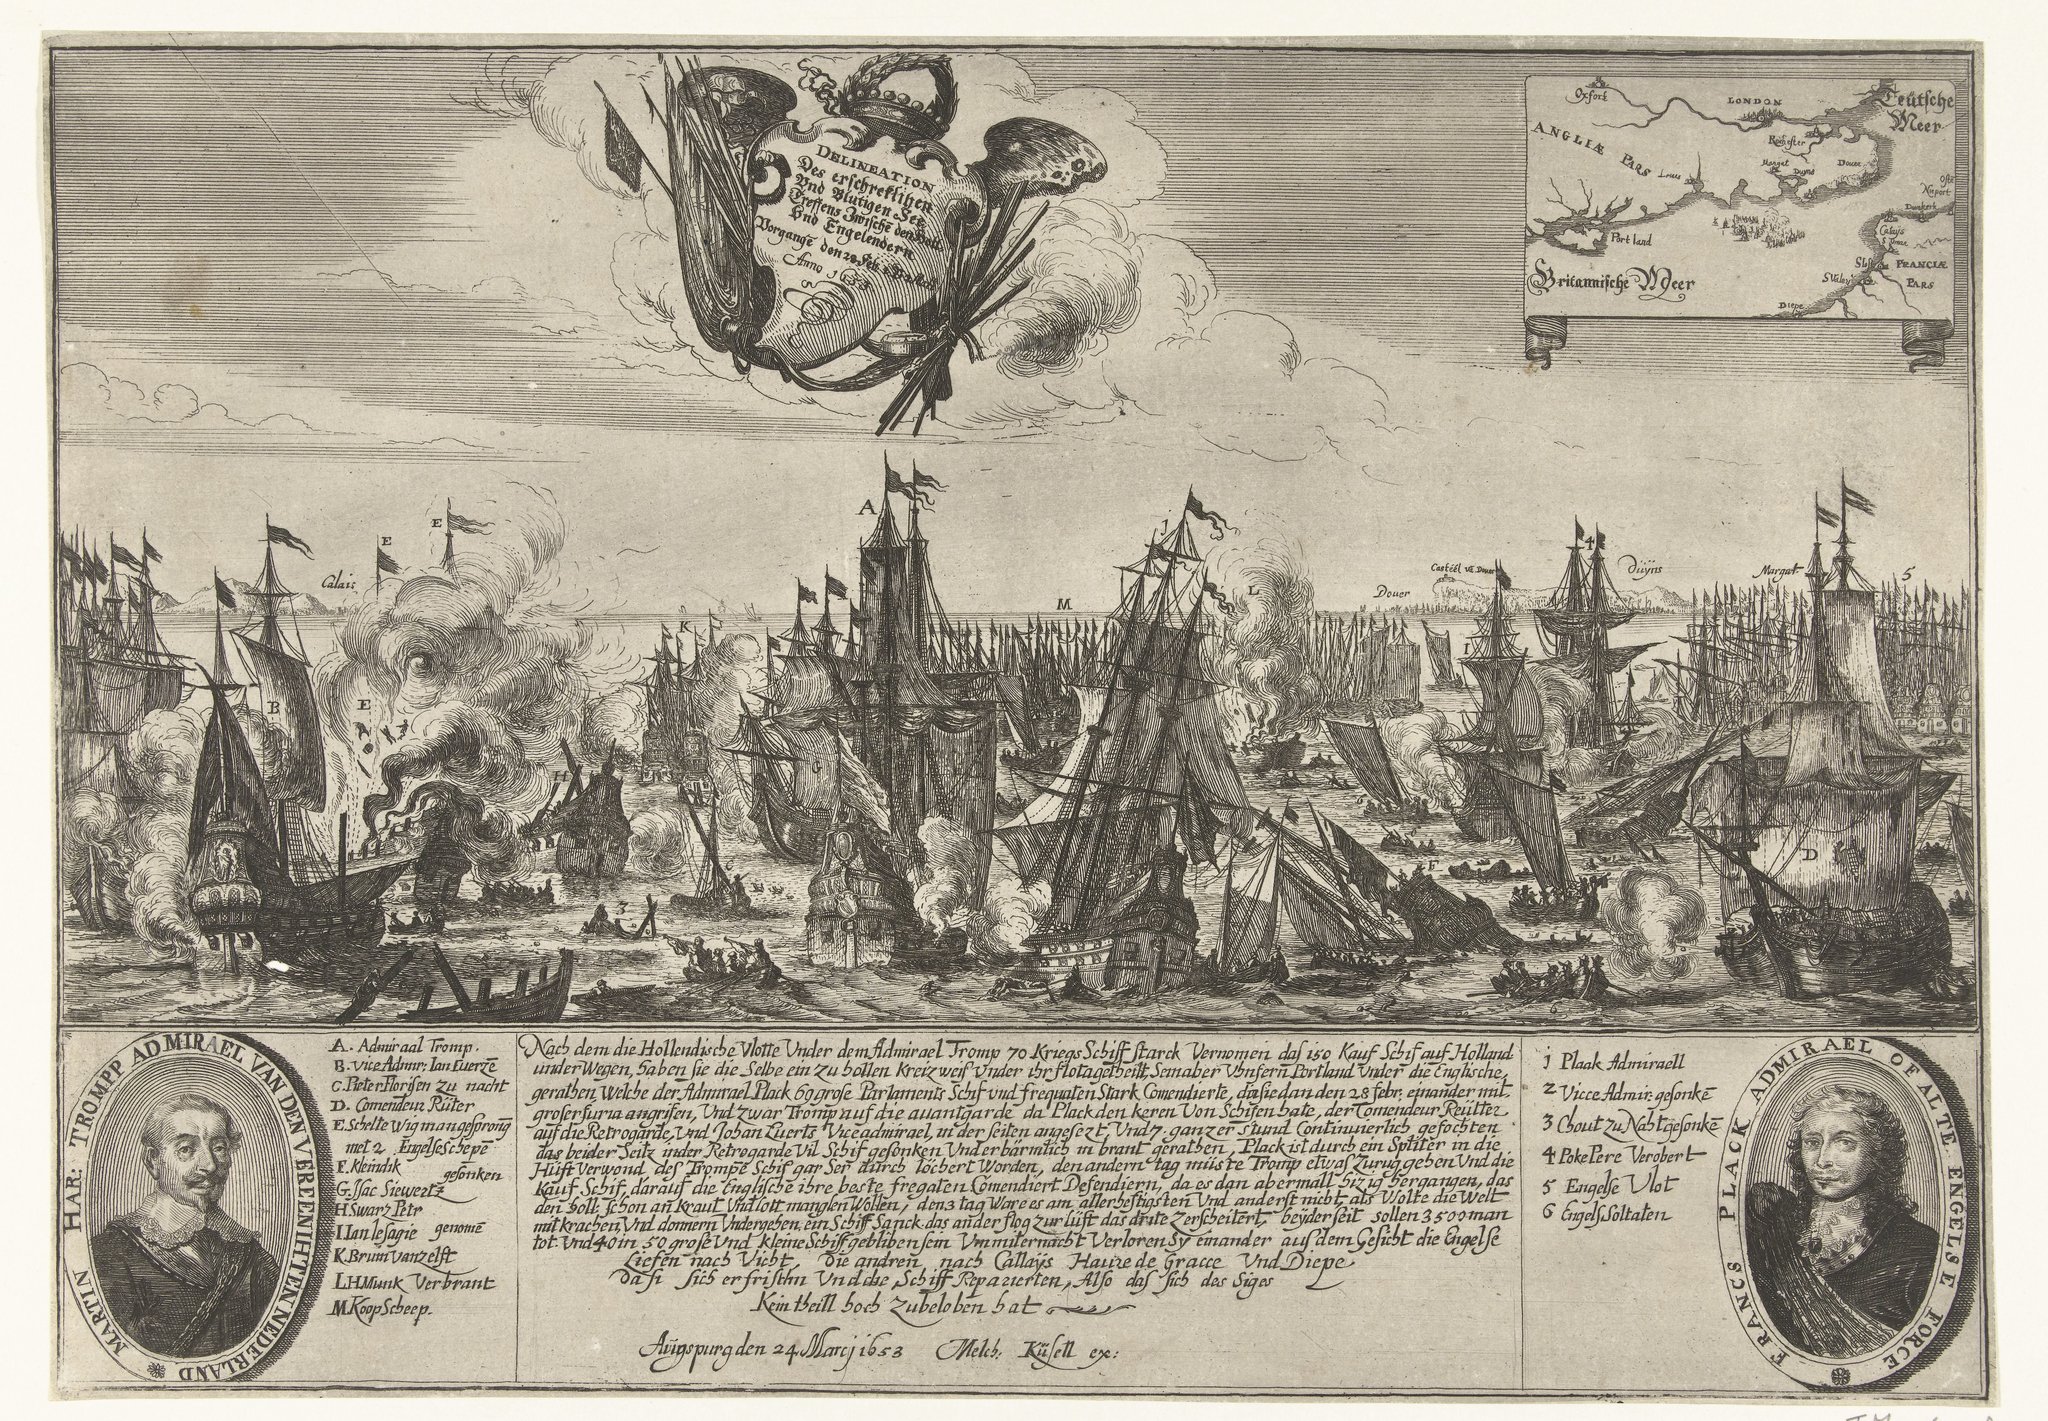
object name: print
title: Delineation Des erschreklichen Und Blutigen See Treffens Zwische[n] den Holl. Und Engelendern Vorgange[n] dem 28 Feb. 1 & 2 Mart Anno 1653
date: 1653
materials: paper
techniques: etching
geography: germany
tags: brielle, maarten harpertszoon tromp, battle (+ naval force), battle of portland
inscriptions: date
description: Driedaagse Zeeslag voor de Engelse zuidkust in de Eerste Engelse Oorlog tussen de Staatse vloot onder Maarten Tromp en de Engelse vloot onder Robert Blake, 28 februari - 2 maart 1653. Centraal de zeeslag, in de lucht een gevleugelde cartouche met de titel, rechtsboven een inzet met een kaart van het Kanaal. Onderaan een beschrijving van de gebeurtenissen geflankeerd door ovale portretten van Tromp en Blake.